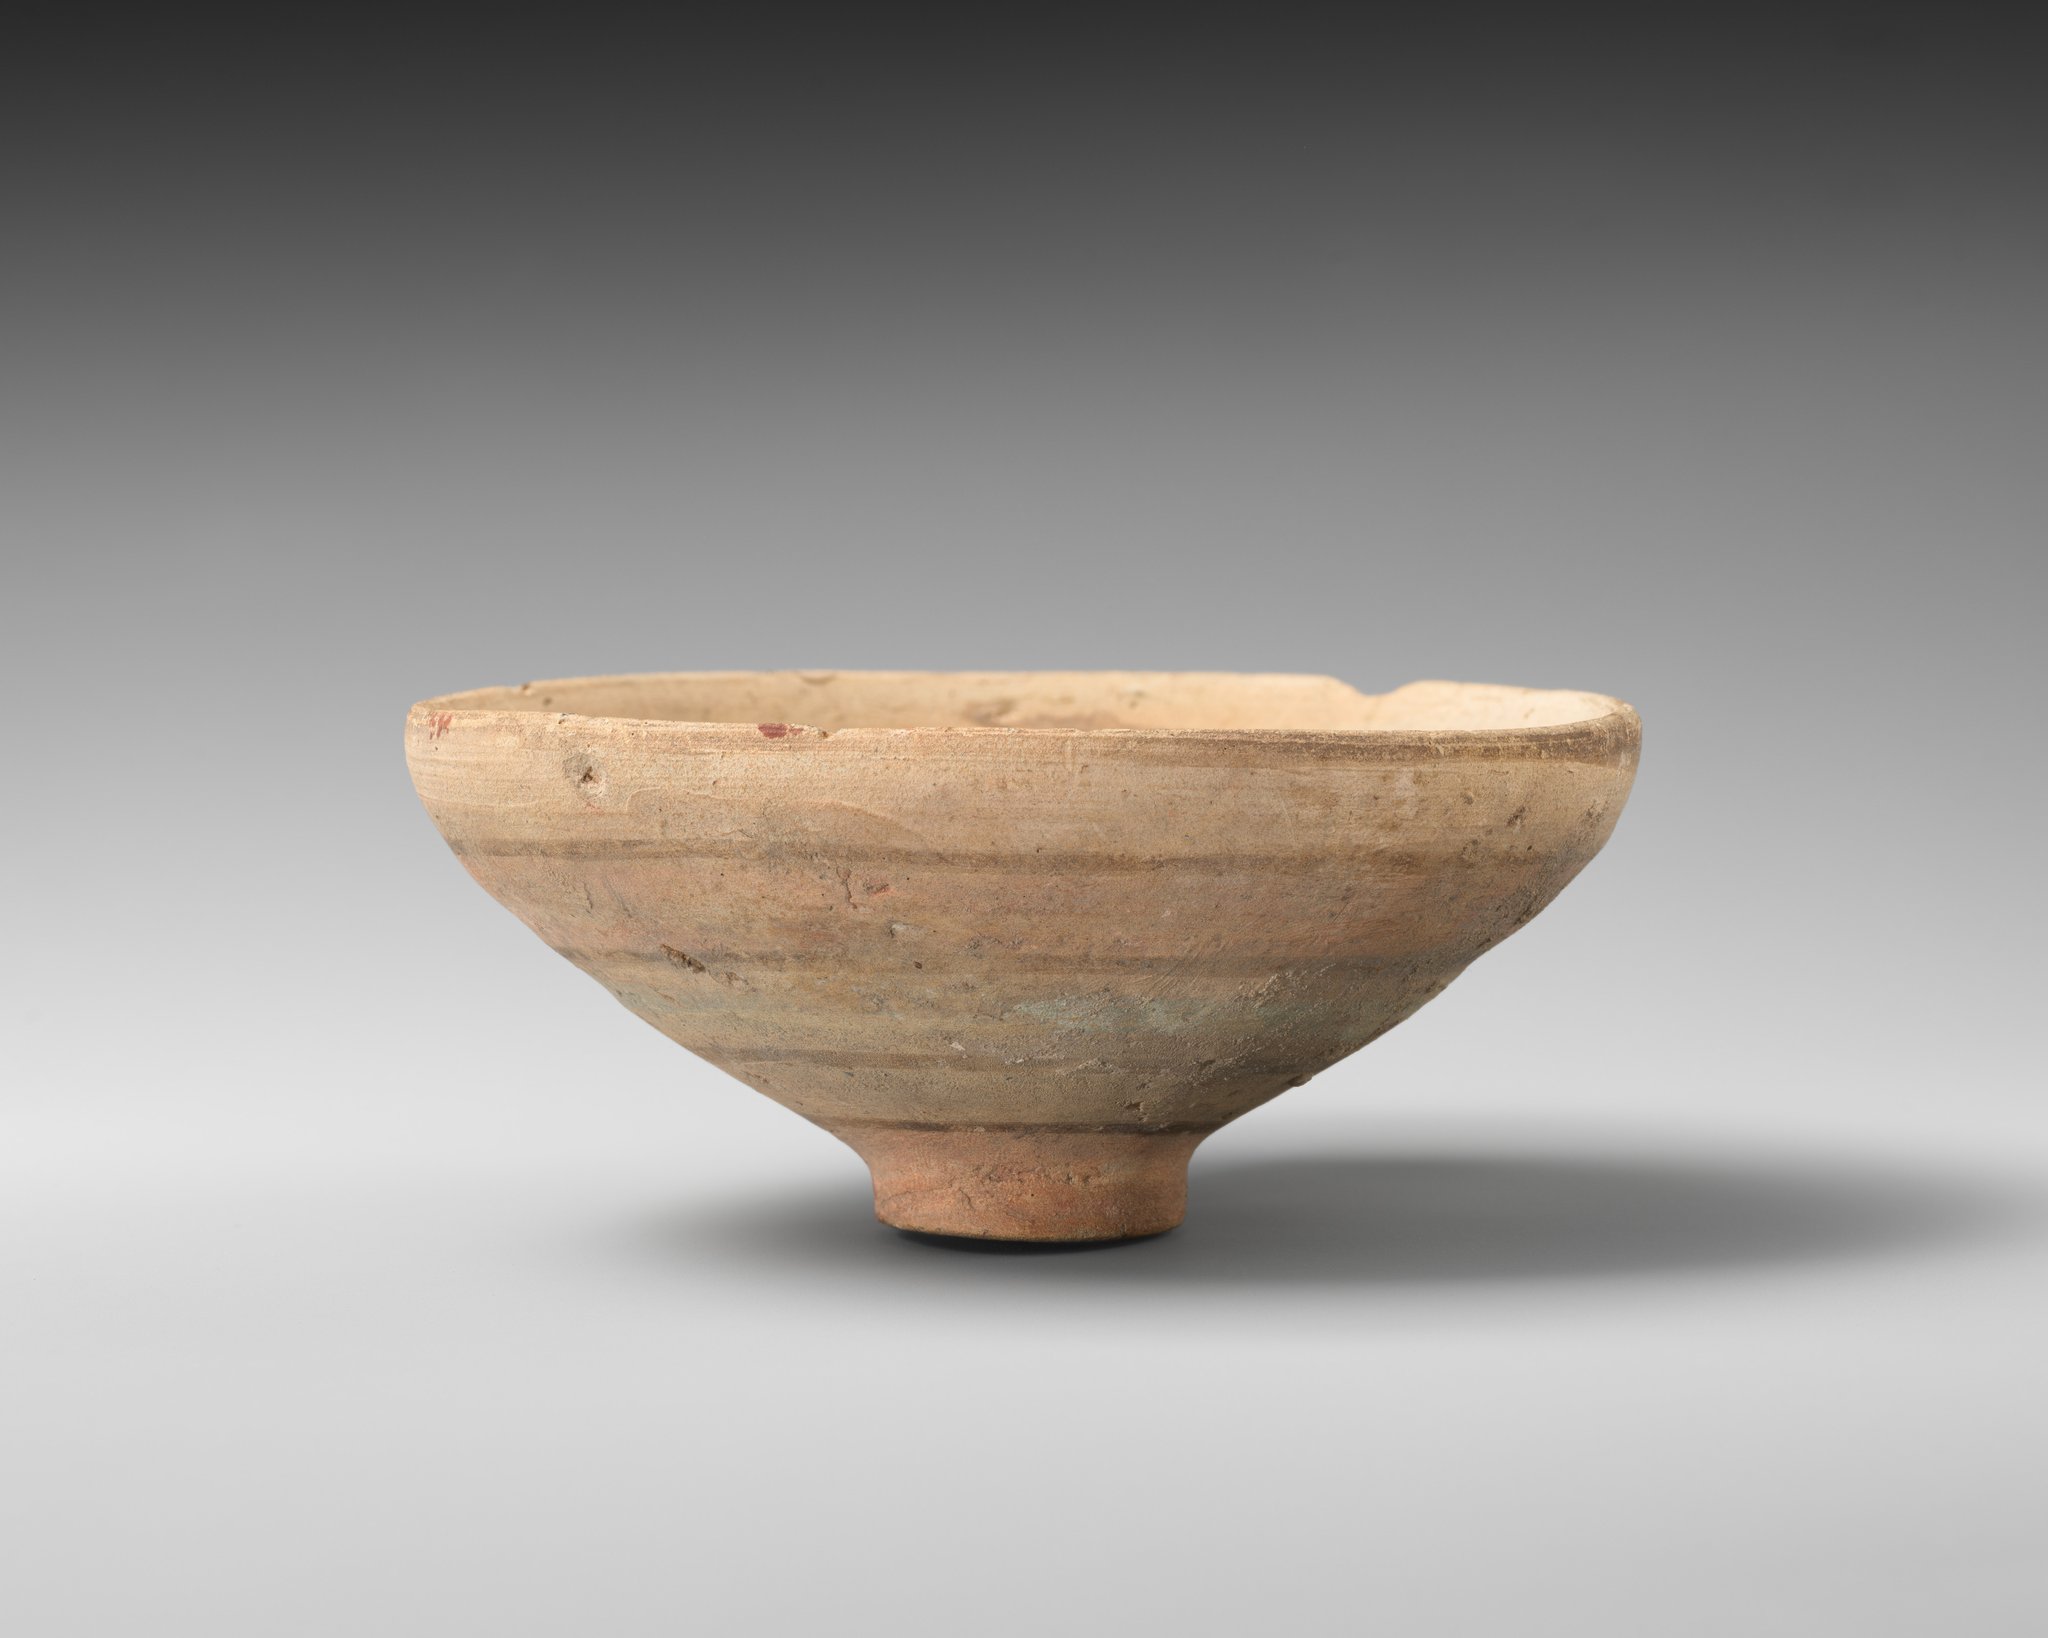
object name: vase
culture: cypriot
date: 750-310 BCE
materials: terracotta